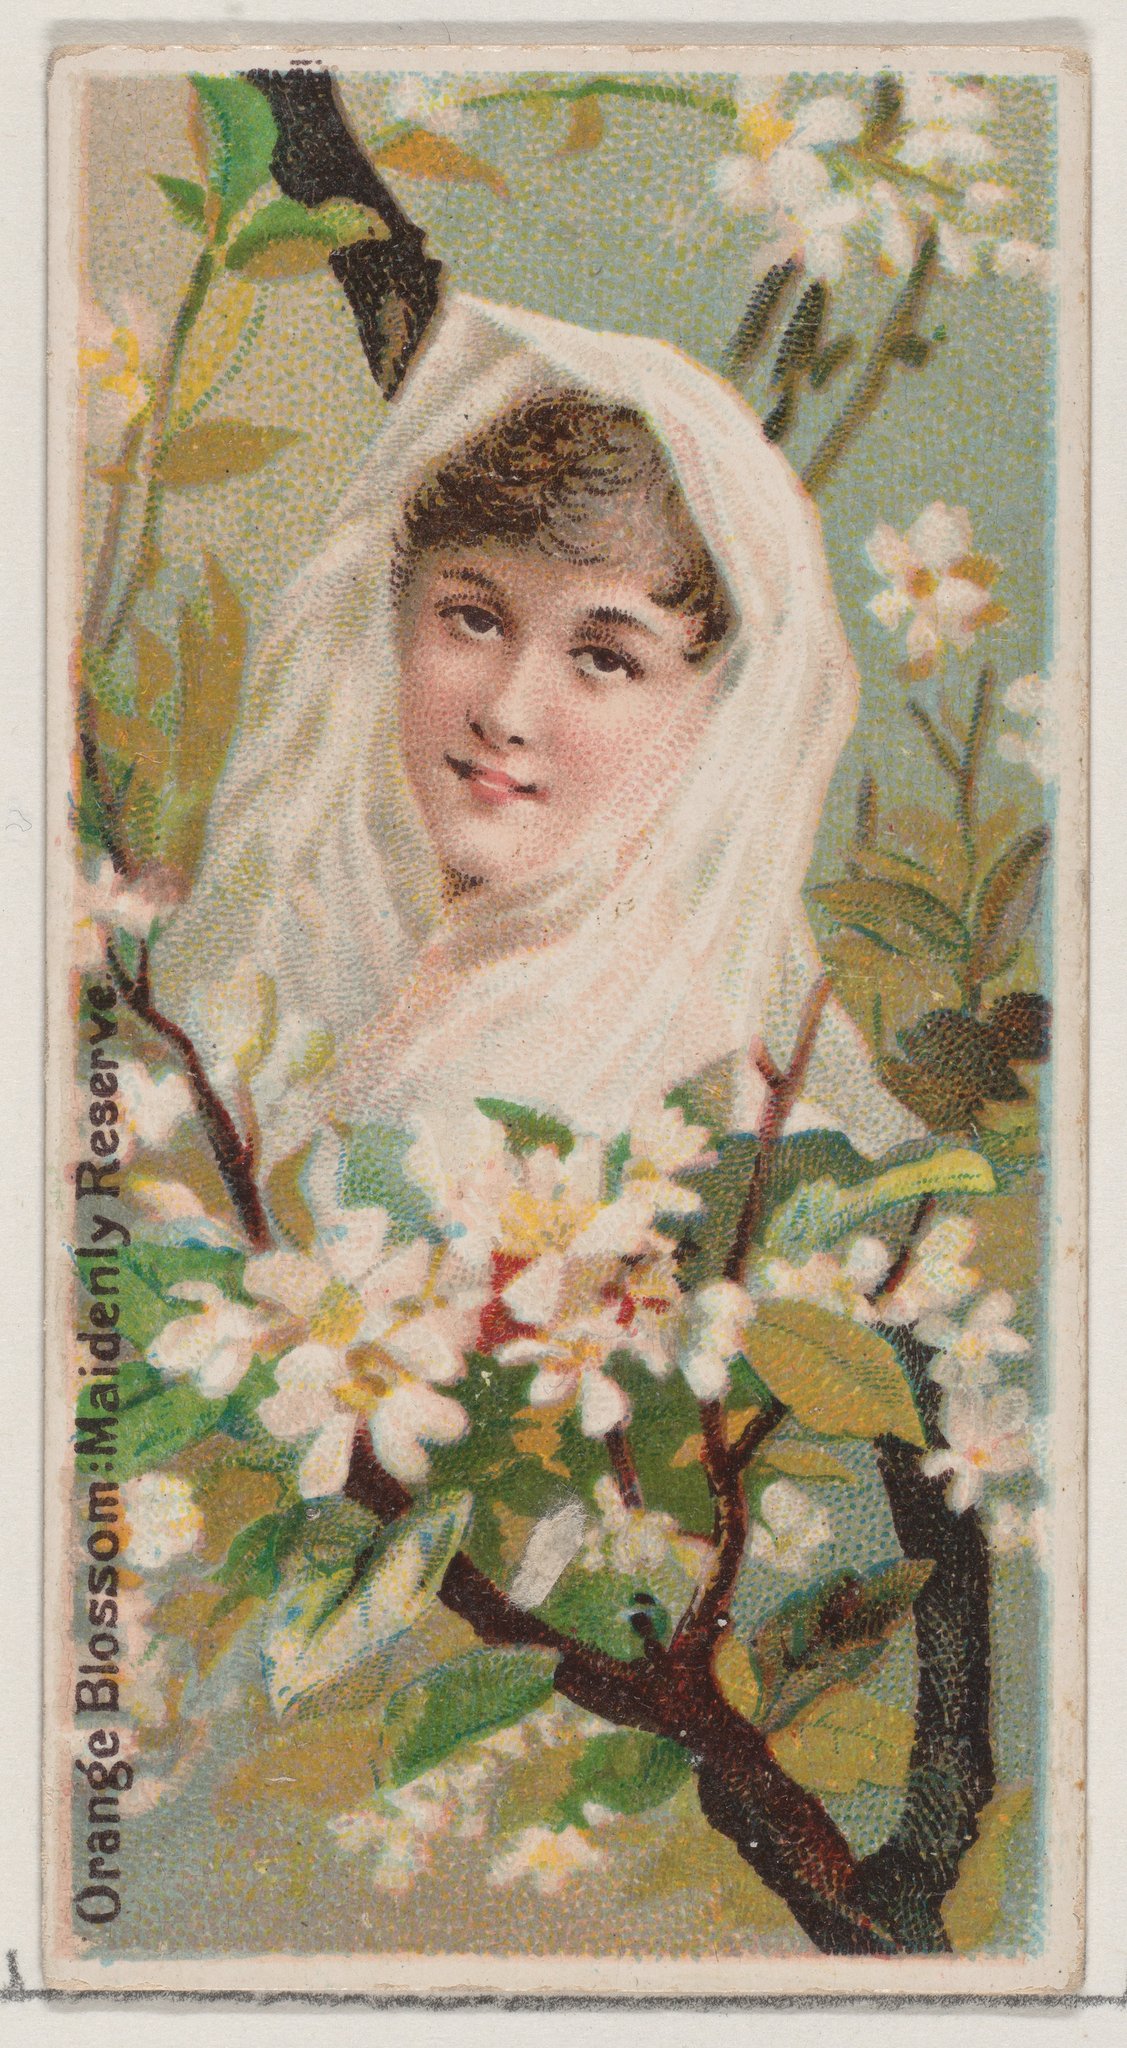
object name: print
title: Orange Blossom: Maidenly Reserve, from the series Floral Beauties and Language of Flowers (N75) for Duke brand cigarettes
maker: american tobacco company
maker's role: publisher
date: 1892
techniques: color lithograph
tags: women,flowers